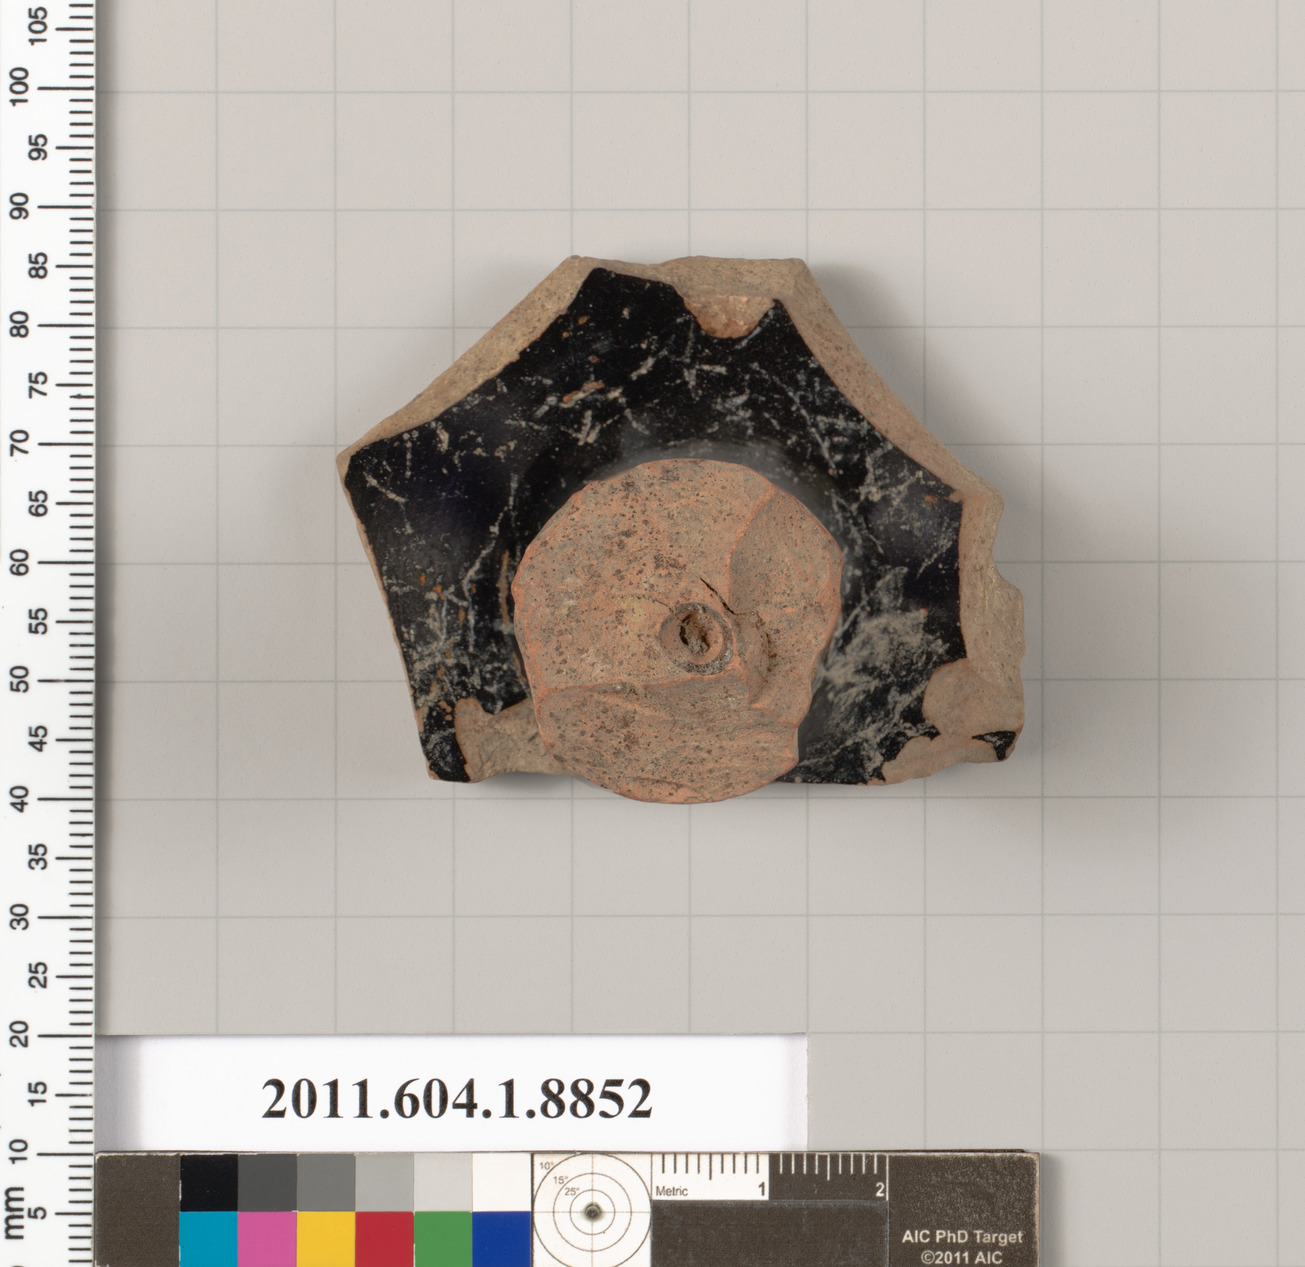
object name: kylix fragment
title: Terracotta fragment of a kylix (drinking cup)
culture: greek, attic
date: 534-468 BCE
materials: terracotta